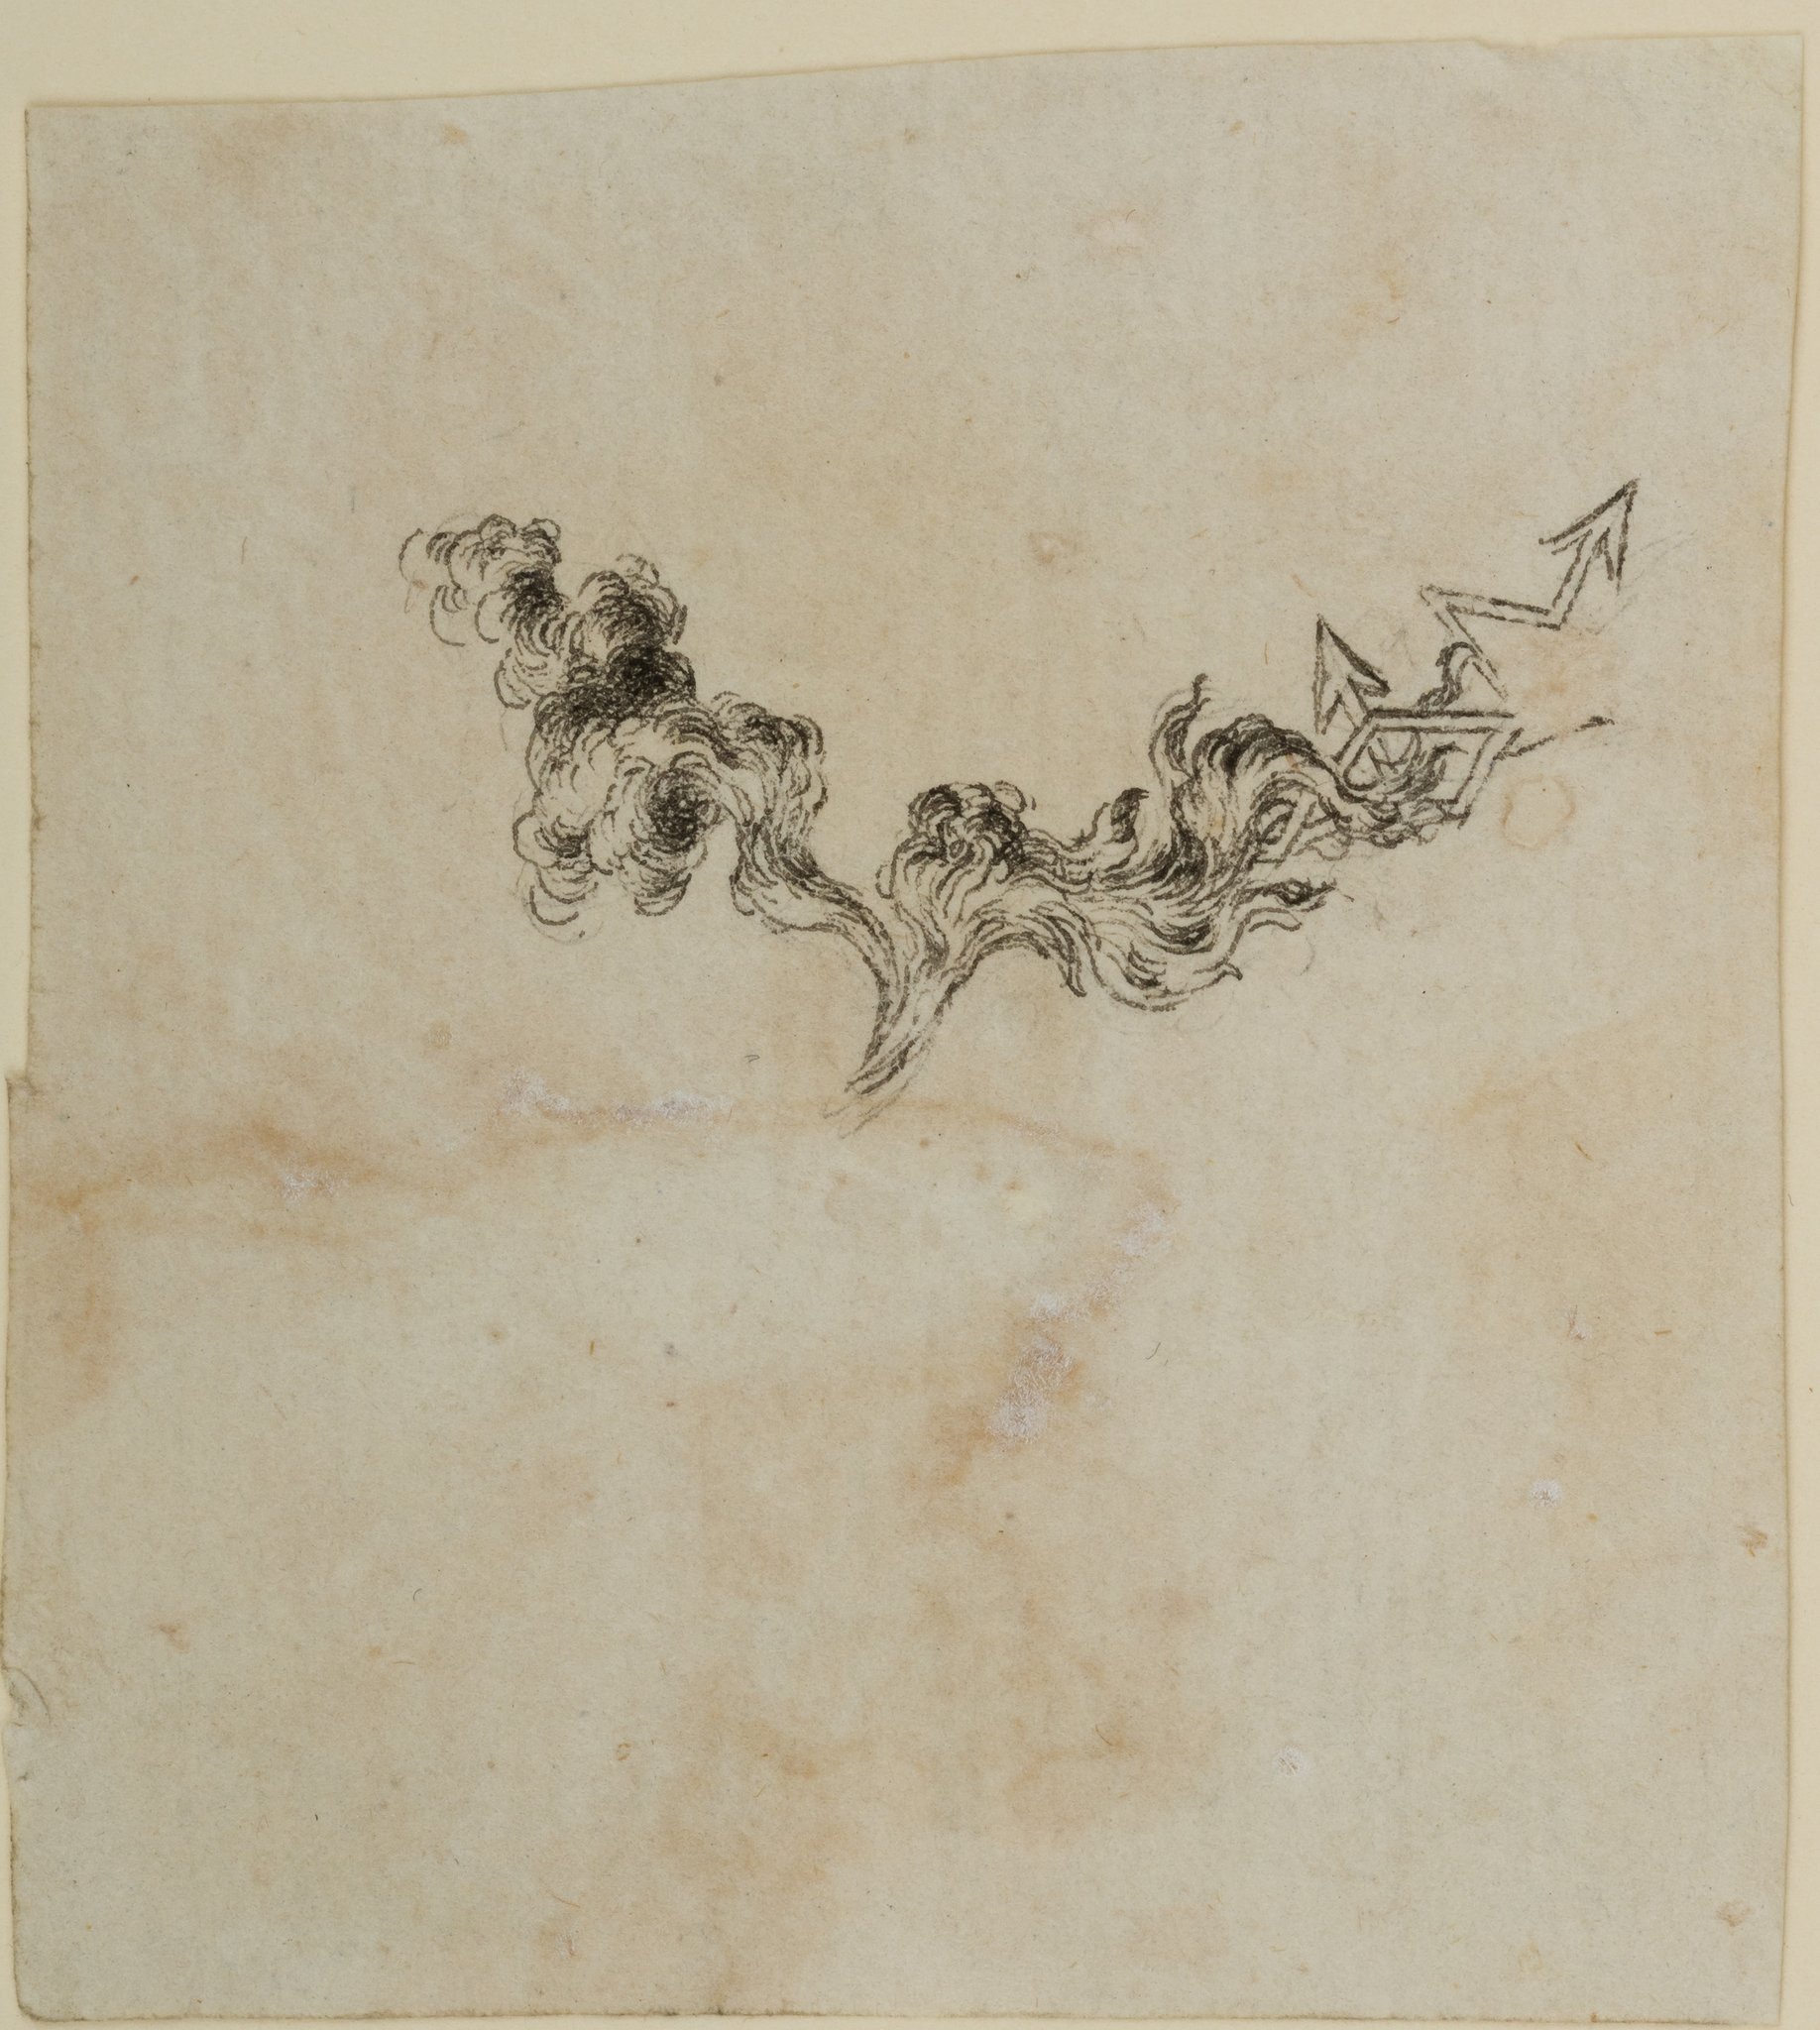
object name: drawing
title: Design for the Decoration of Firearms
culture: french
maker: nicolas noël boutet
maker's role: designer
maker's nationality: french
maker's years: 1761-1833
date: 1797-1805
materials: ink, paper, pencil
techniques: wash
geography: france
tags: ornament